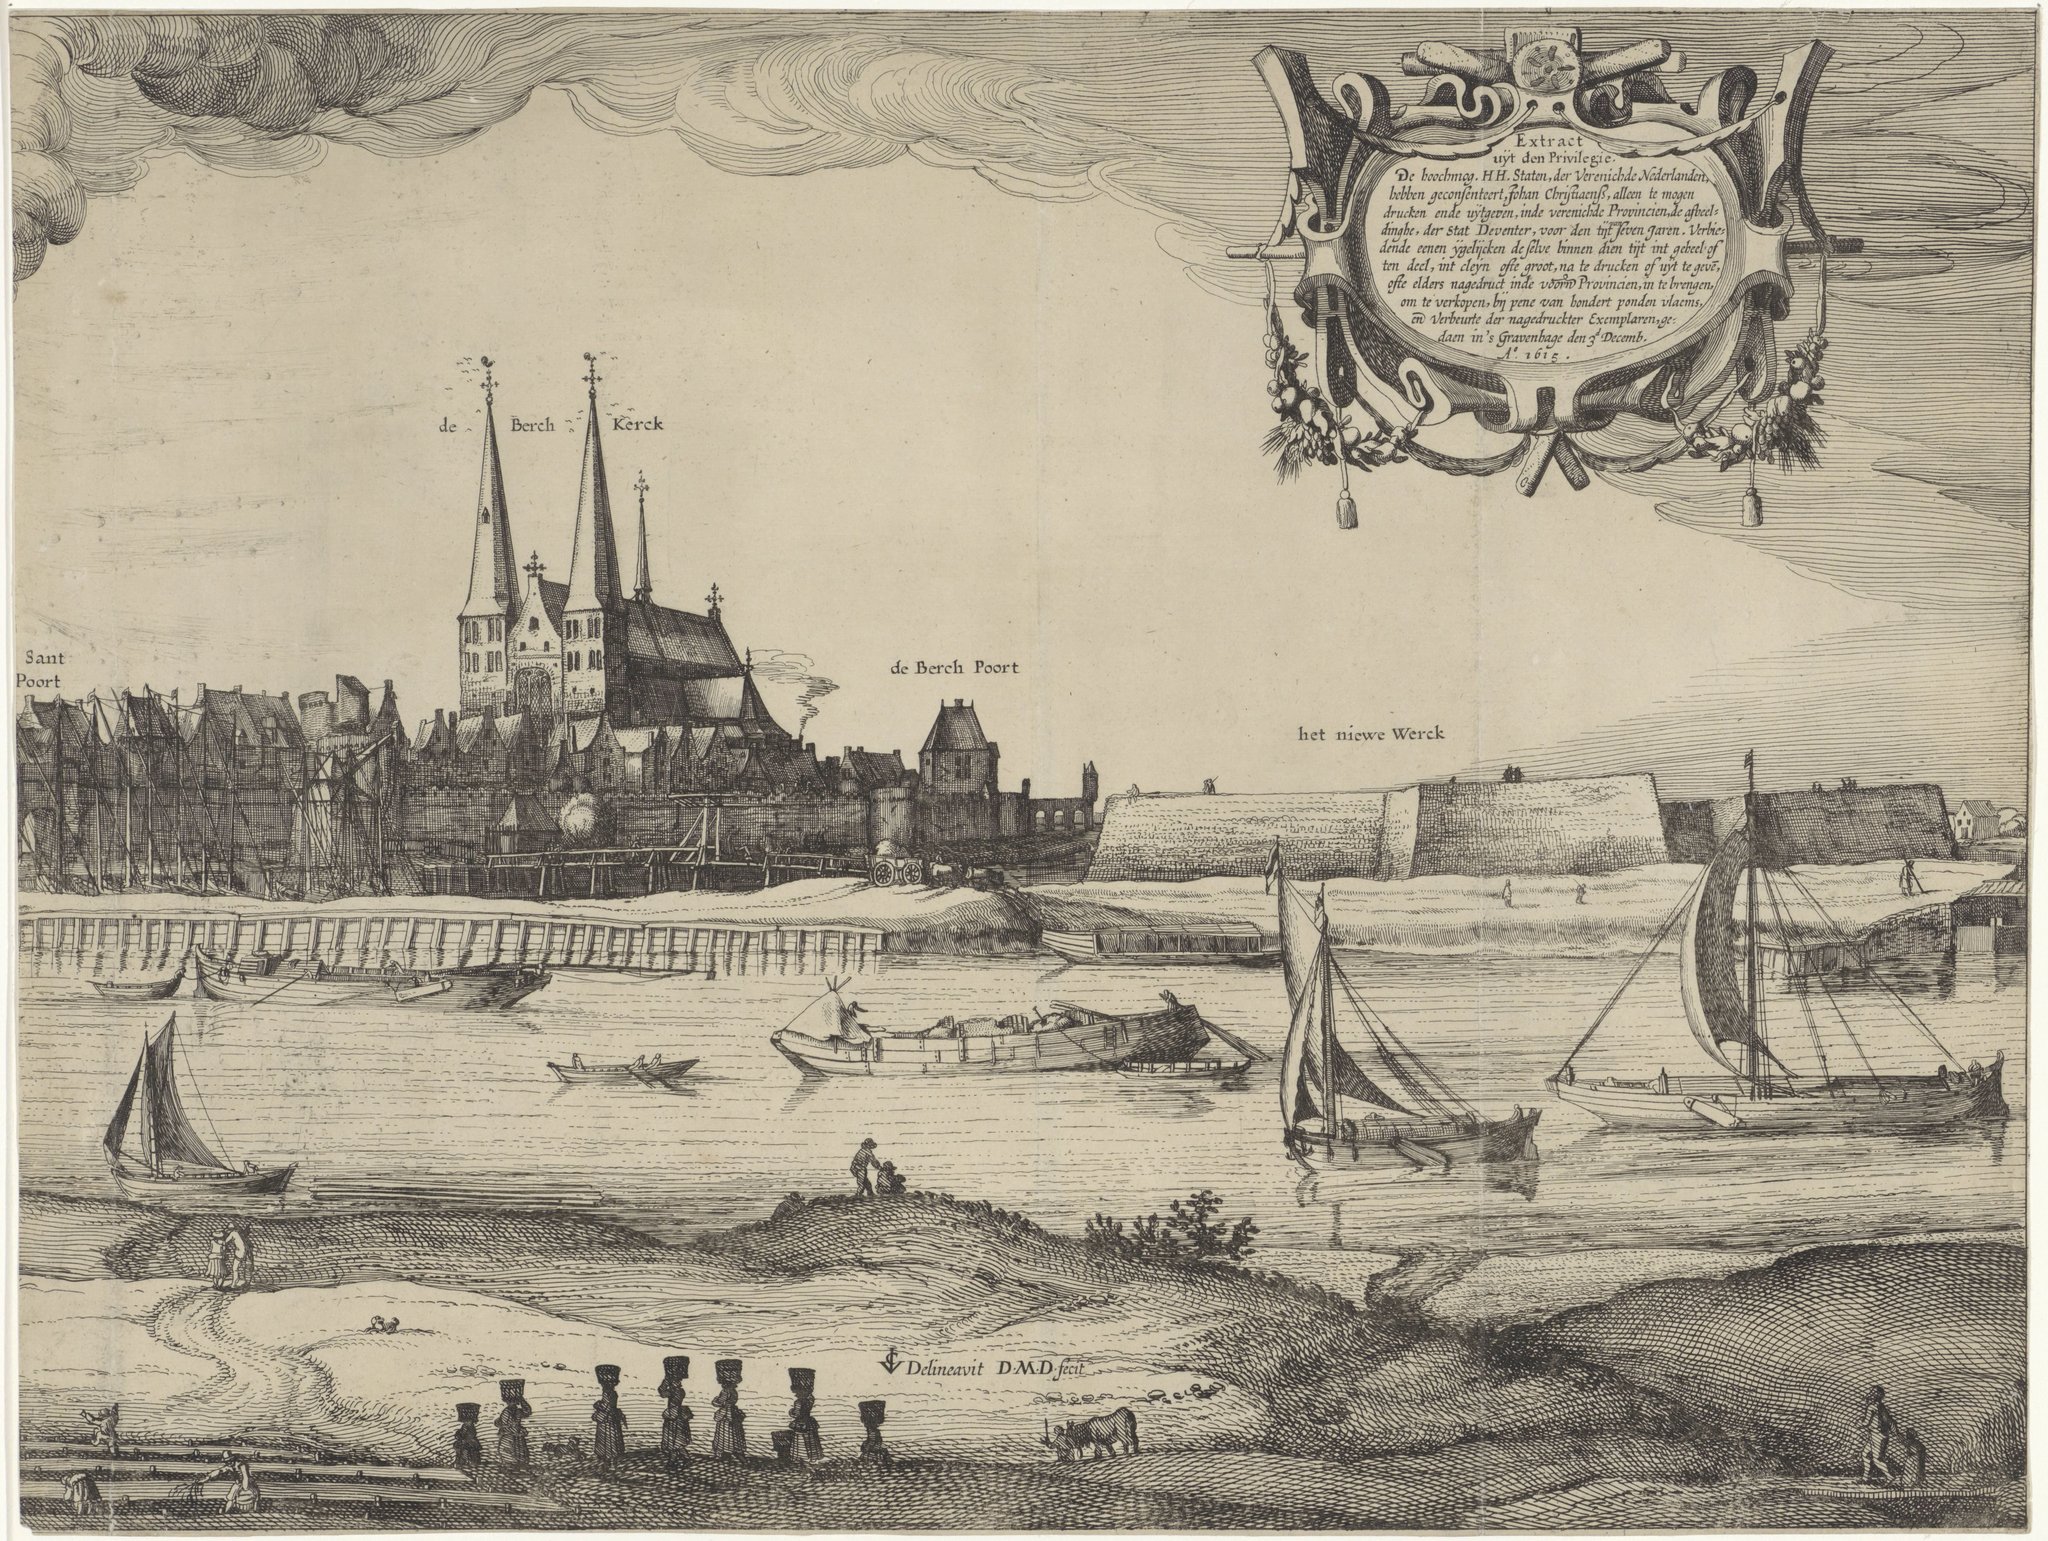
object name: print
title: Profiel van Deventer (plaat IV)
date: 1615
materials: paper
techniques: etching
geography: amsterdam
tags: sailing-ship, sailing-boat, church (exterior), prospect of city, town panorama, silhouette of city, deventer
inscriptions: collector's mark: Lugt 2228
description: Rechterplaat van 'Profiel van Deventer', met een gezicht op een gedeelte van de stad Deventer. Op de voorgrond wordt op het land gewerkt. Op de IJssel zeilen diverse boten. Op de achtergrond vestingwerken, de stadspoort en de Sint-Nicolaas- of Bergkerk. Rechtsboven een cartouche waarin het privilege en de datering.